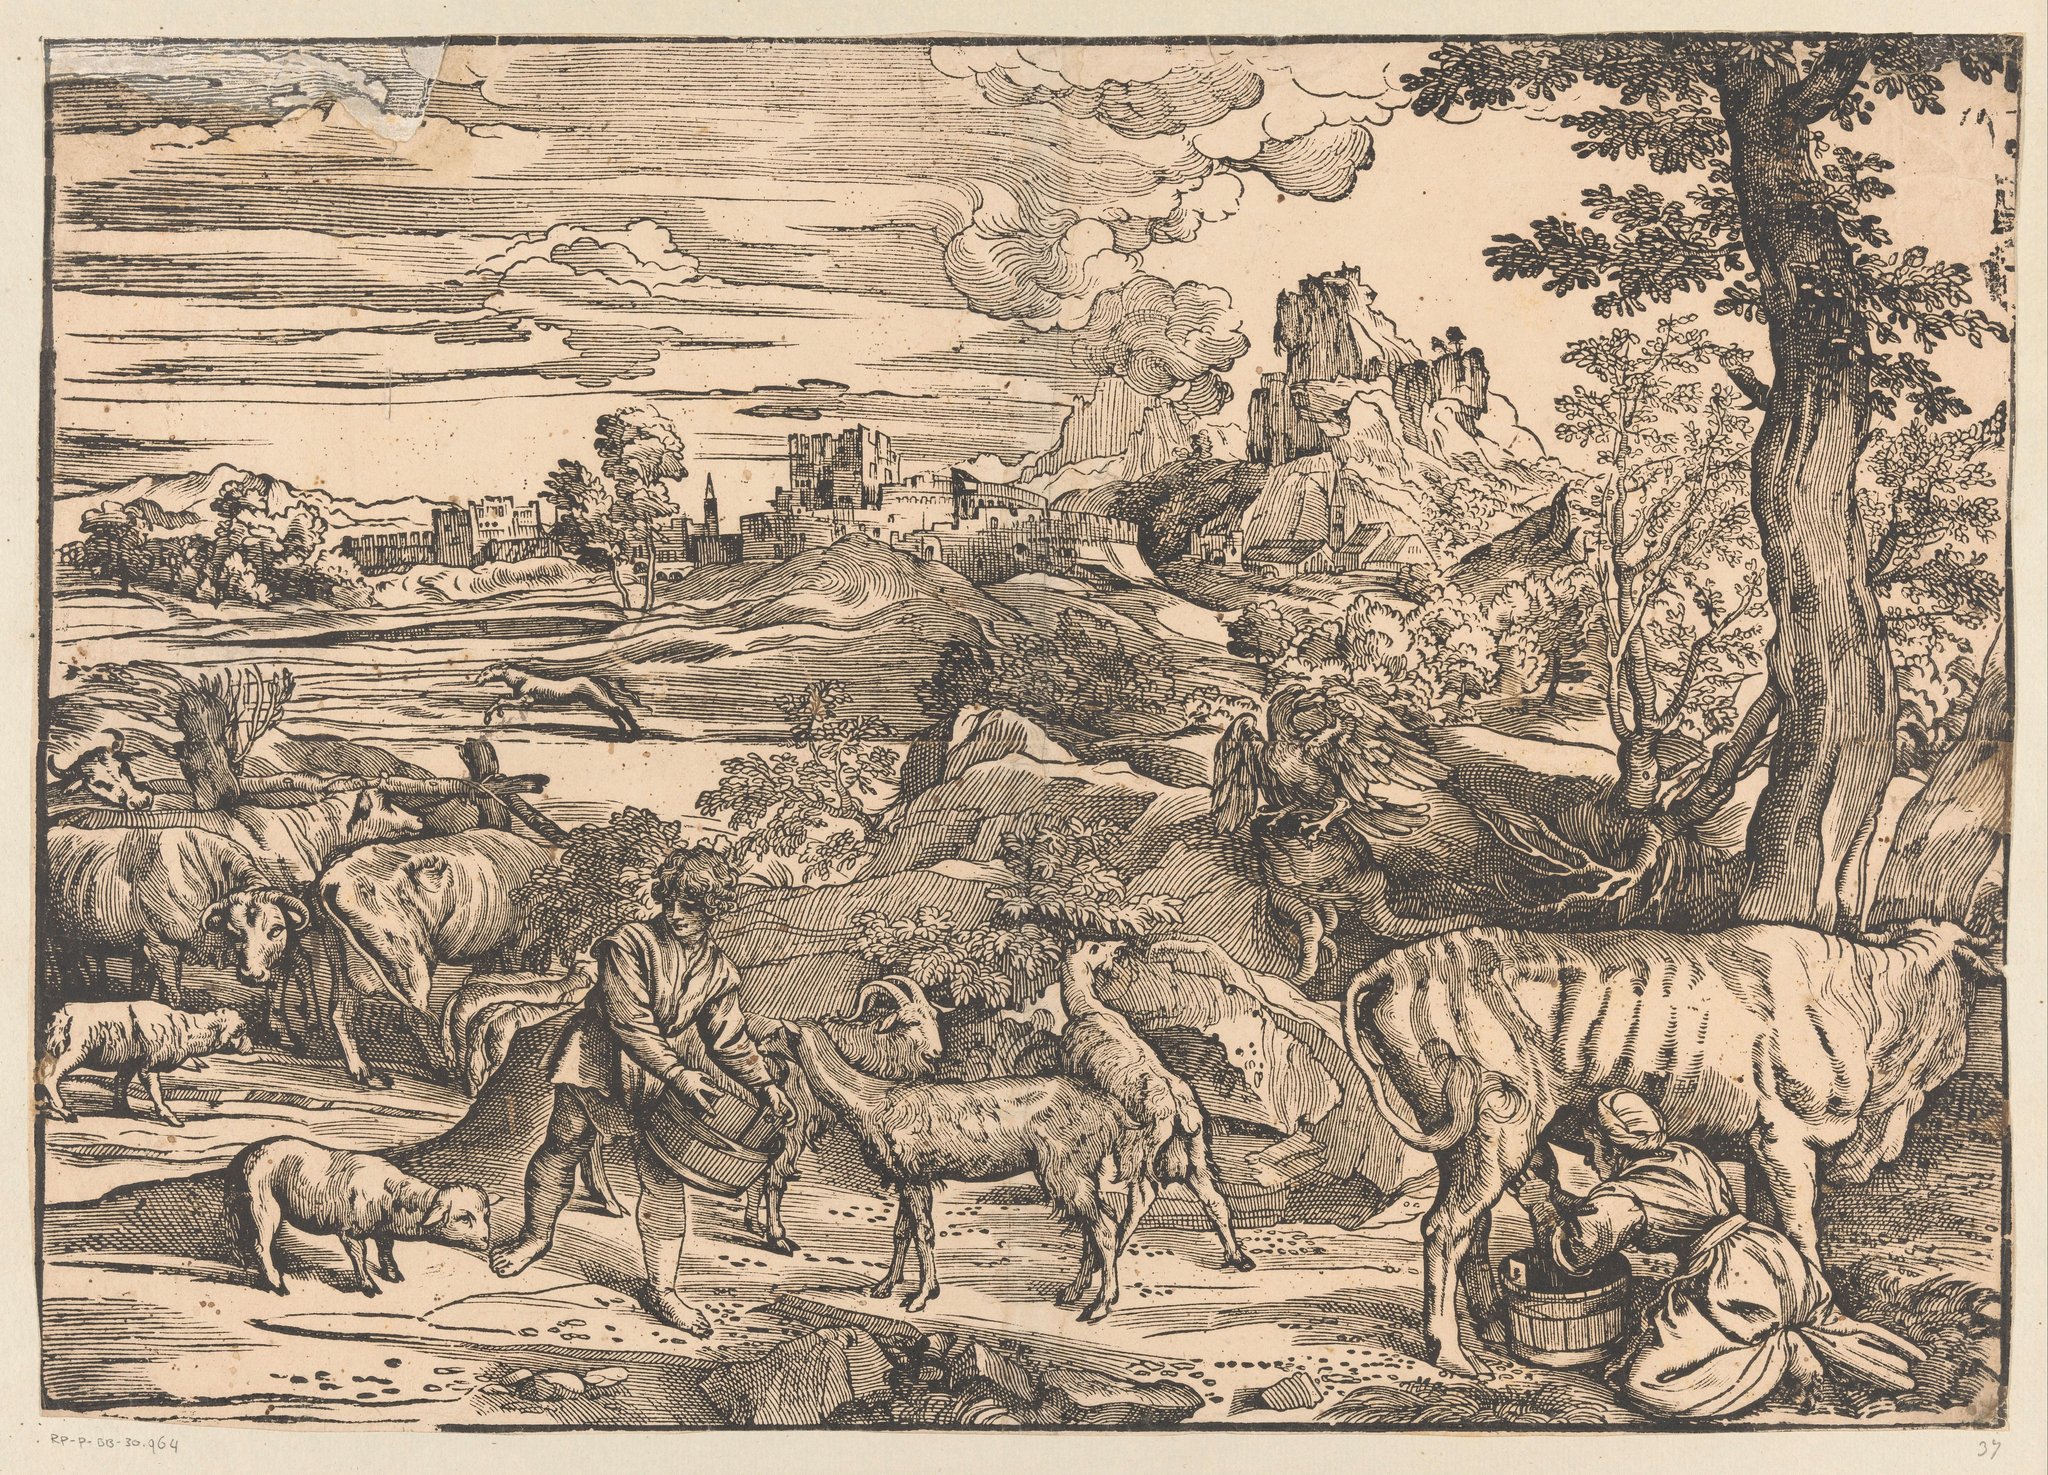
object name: print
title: Landschap met melkmeid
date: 1525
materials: ink, paper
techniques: pen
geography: venice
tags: cow, predatory birds: eagle, herding, herdsman, herdswoman, shepherd, shepherdess, cowherd, etc., sheep, goat, milkmaid, mountains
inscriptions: collector's mark: Lugt 240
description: Op de prent zijn meerdere sporen zichtbaar van beschadigingen in het houtblok, zoals een horizontale barst door het midden van de voorstelling. De kleine lege rechthoek (hier aangevuld met arceringen met pen in bruin) naast de adelaar is vermoedelijk het gevolg van een gat in het houtblok. Een beschadiging in het midden rechts is aangevuld met pen in bruin. Linksboven is een hoek van het papier afgescheurd en aangevuld met pen in grijs op een ander blad.